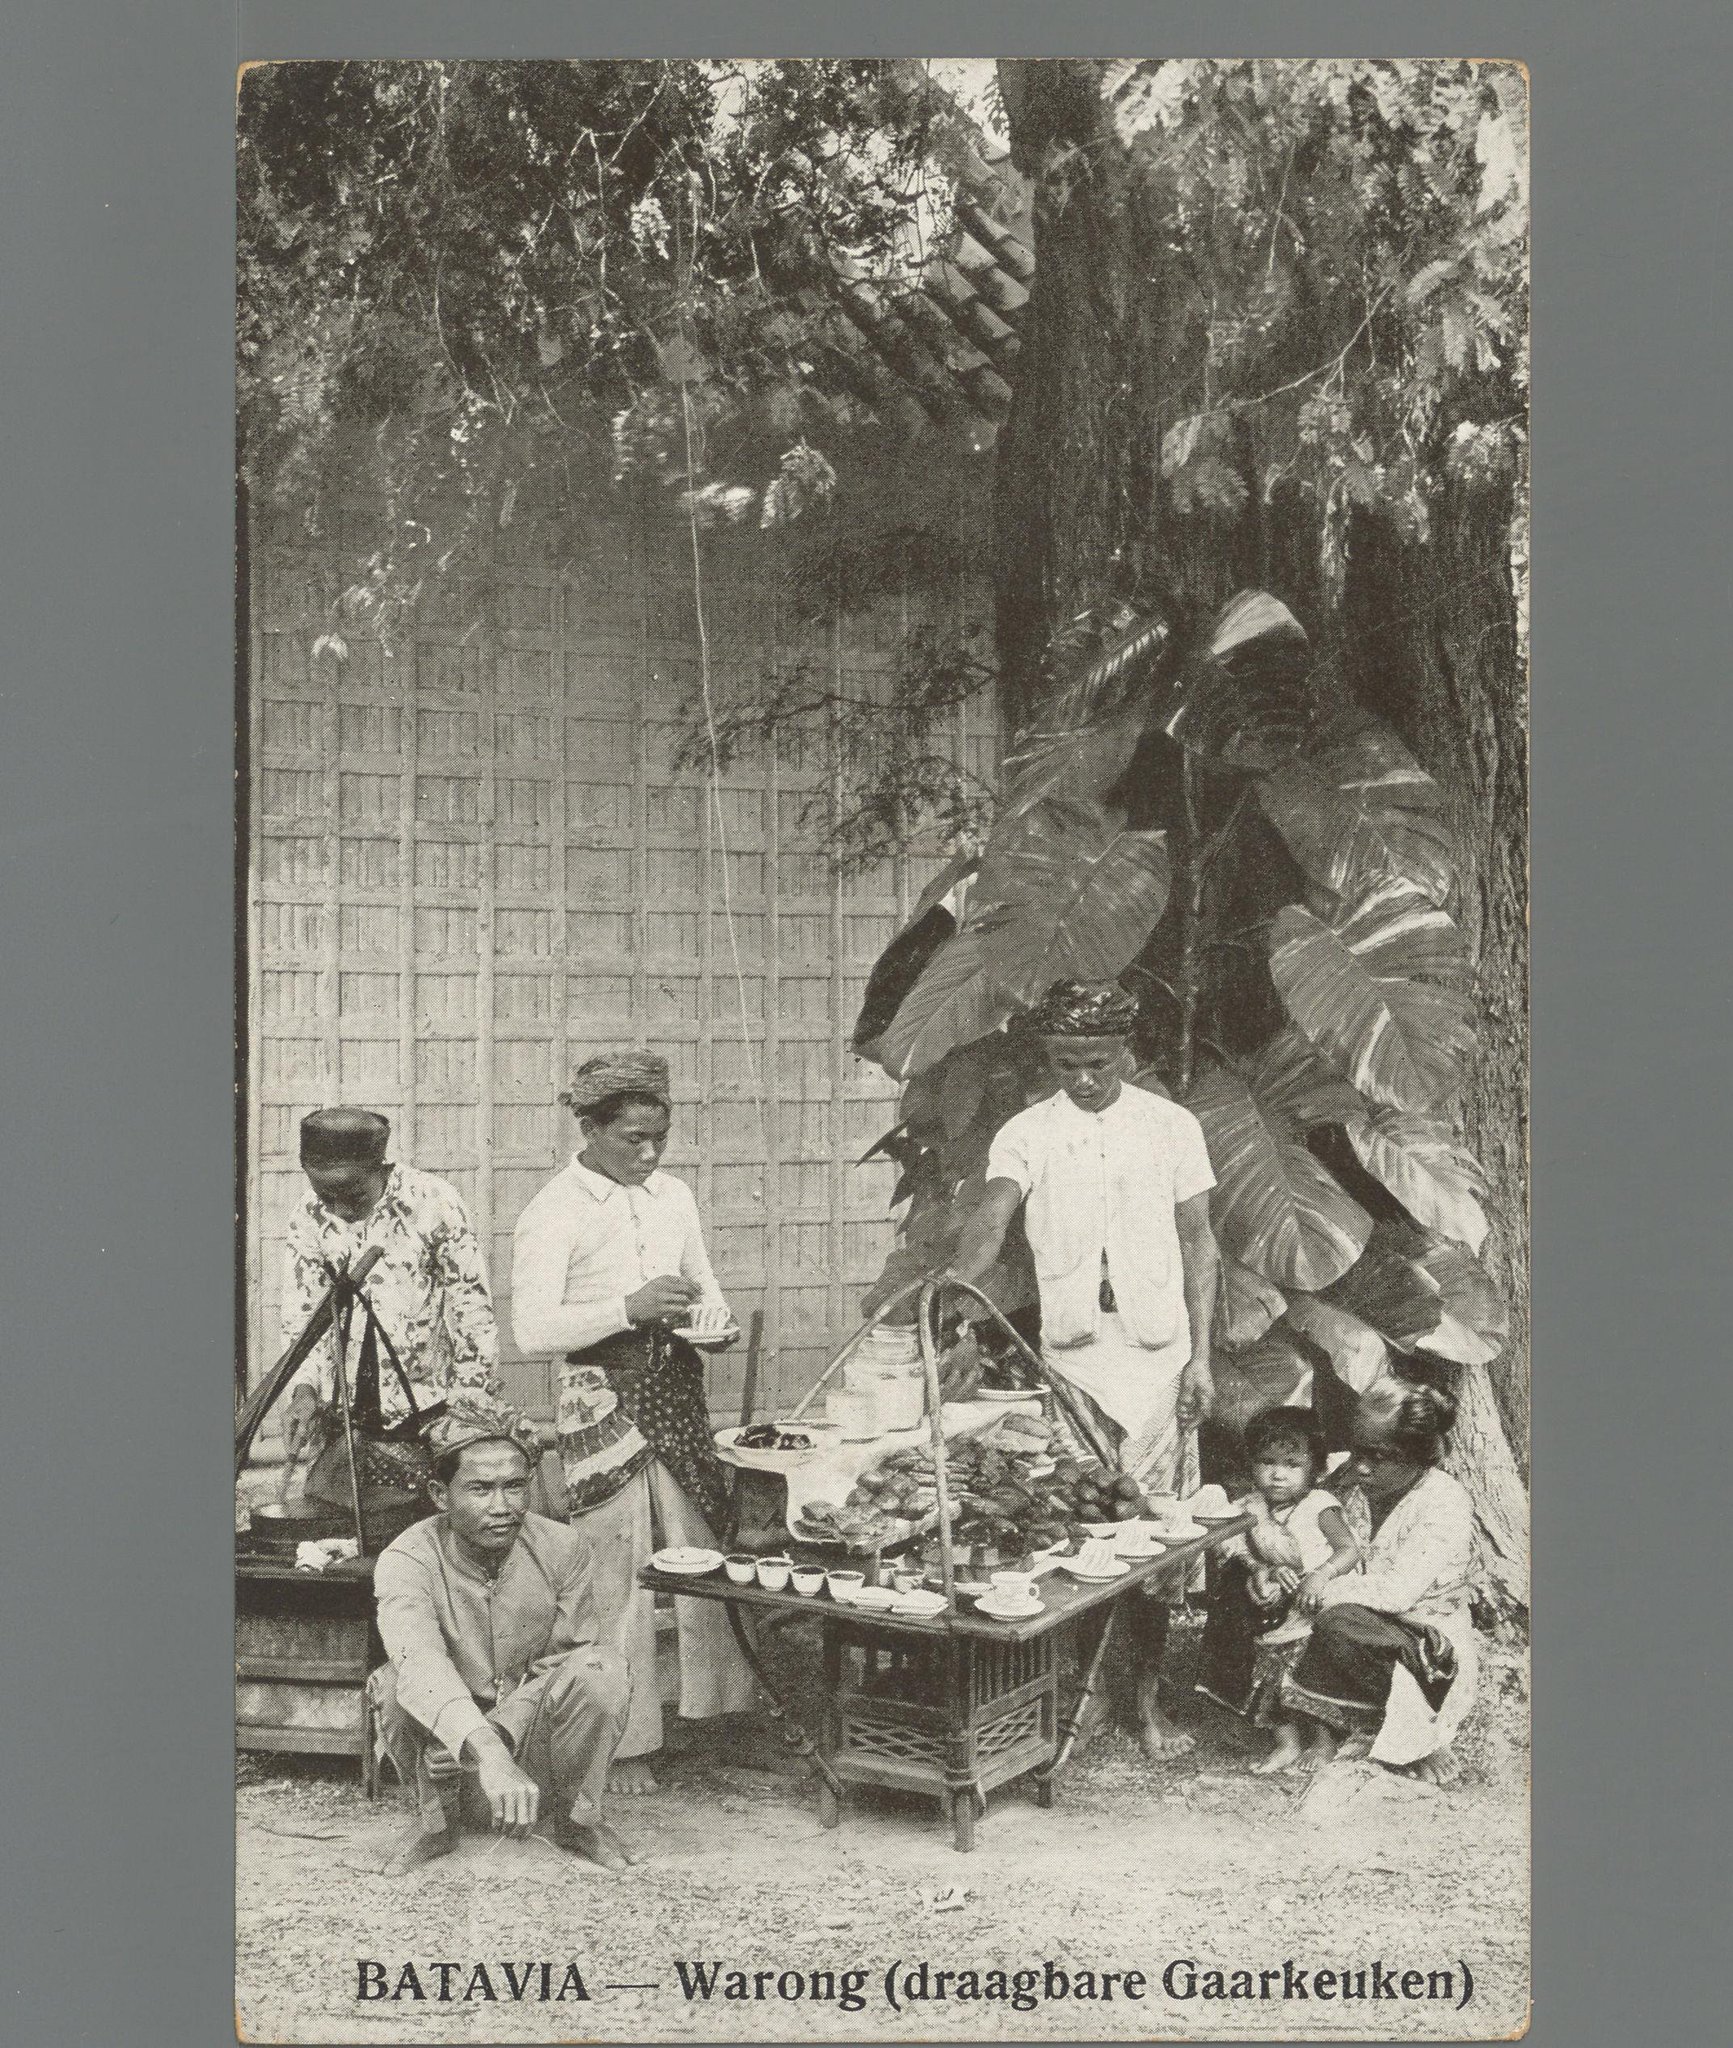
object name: photomechanical print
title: Batavia - Warong (draagbare gaarkeuken)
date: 1906-1930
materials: cardboard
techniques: autotype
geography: weltevreden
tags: open fire, fire-place, stove (in kitchen) - cc - in the open air, batavia